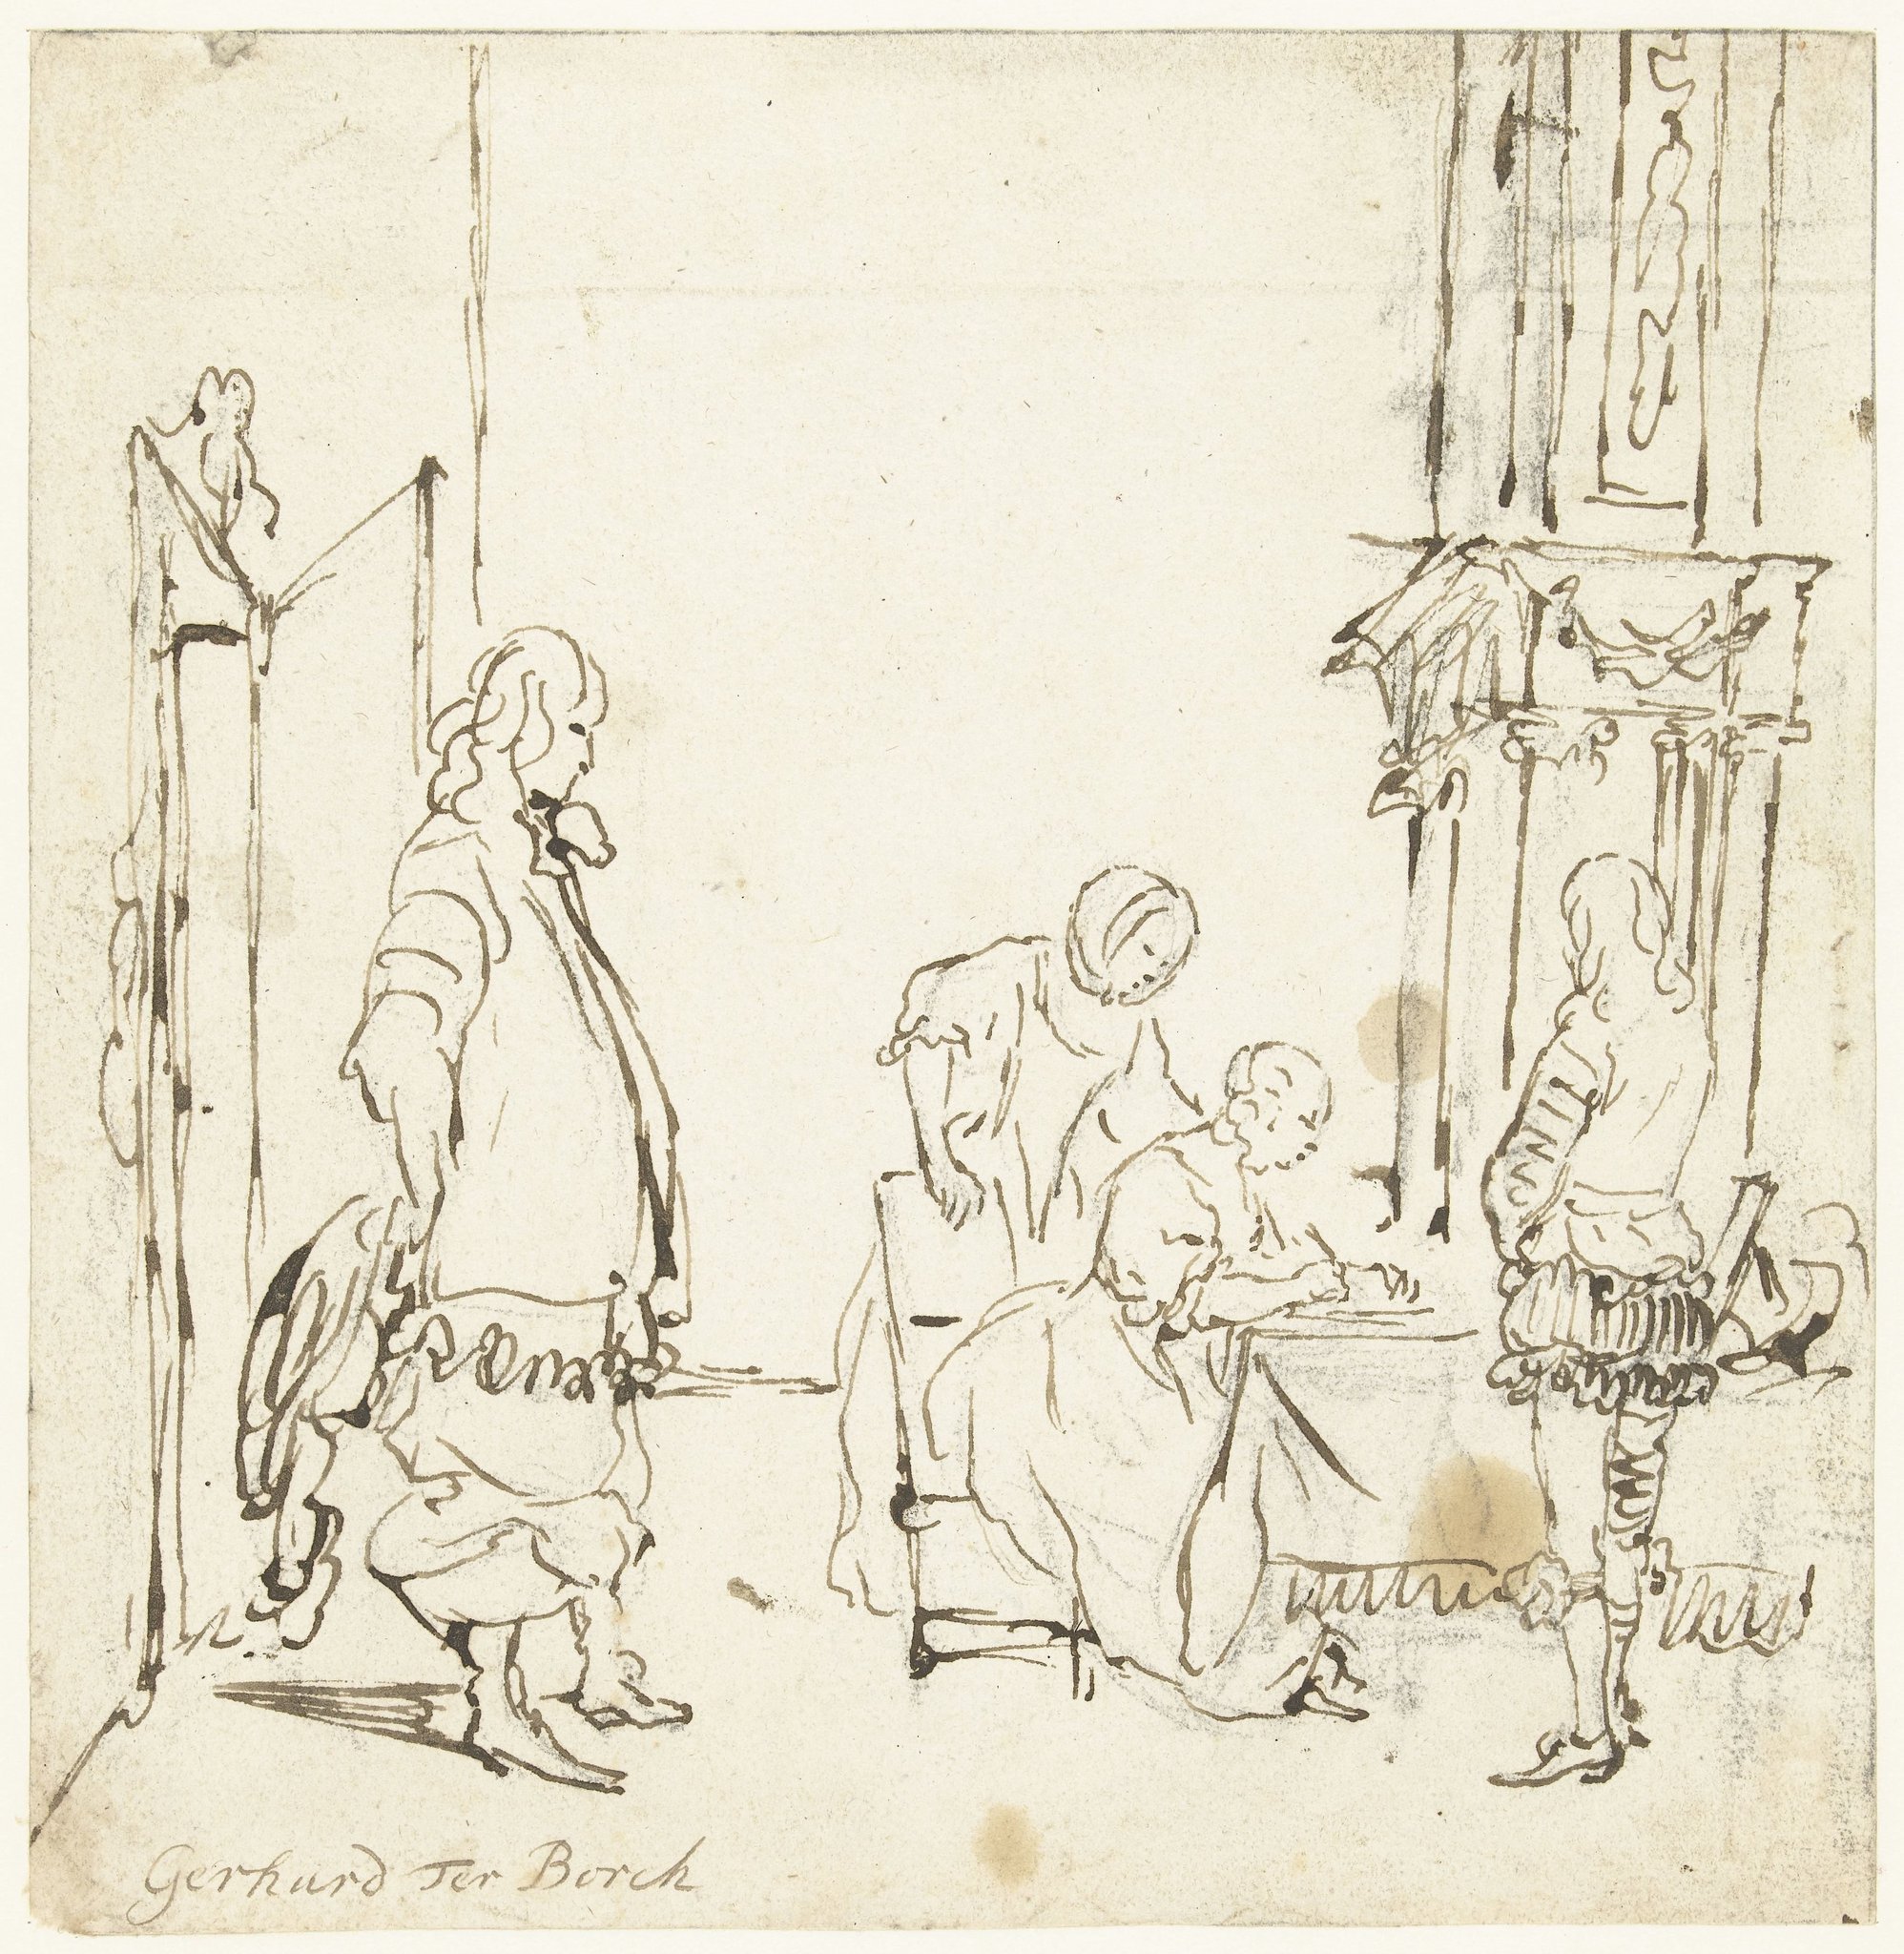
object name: drawing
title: Interieur met een briefschrijvende vrouw, een wachtende man en twee toeschouwers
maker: gerard ter borch (ii)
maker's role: draughtsman, painter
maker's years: 1617-1681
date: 1655-1665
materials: chalk, ink, paper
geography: deventer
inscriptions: annotation: ‘Gerhard Ter Borch’, annotation: ‘copie nr schilderij’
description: Studies voor schilderijen van eind jaren 1650 en begin 1660.